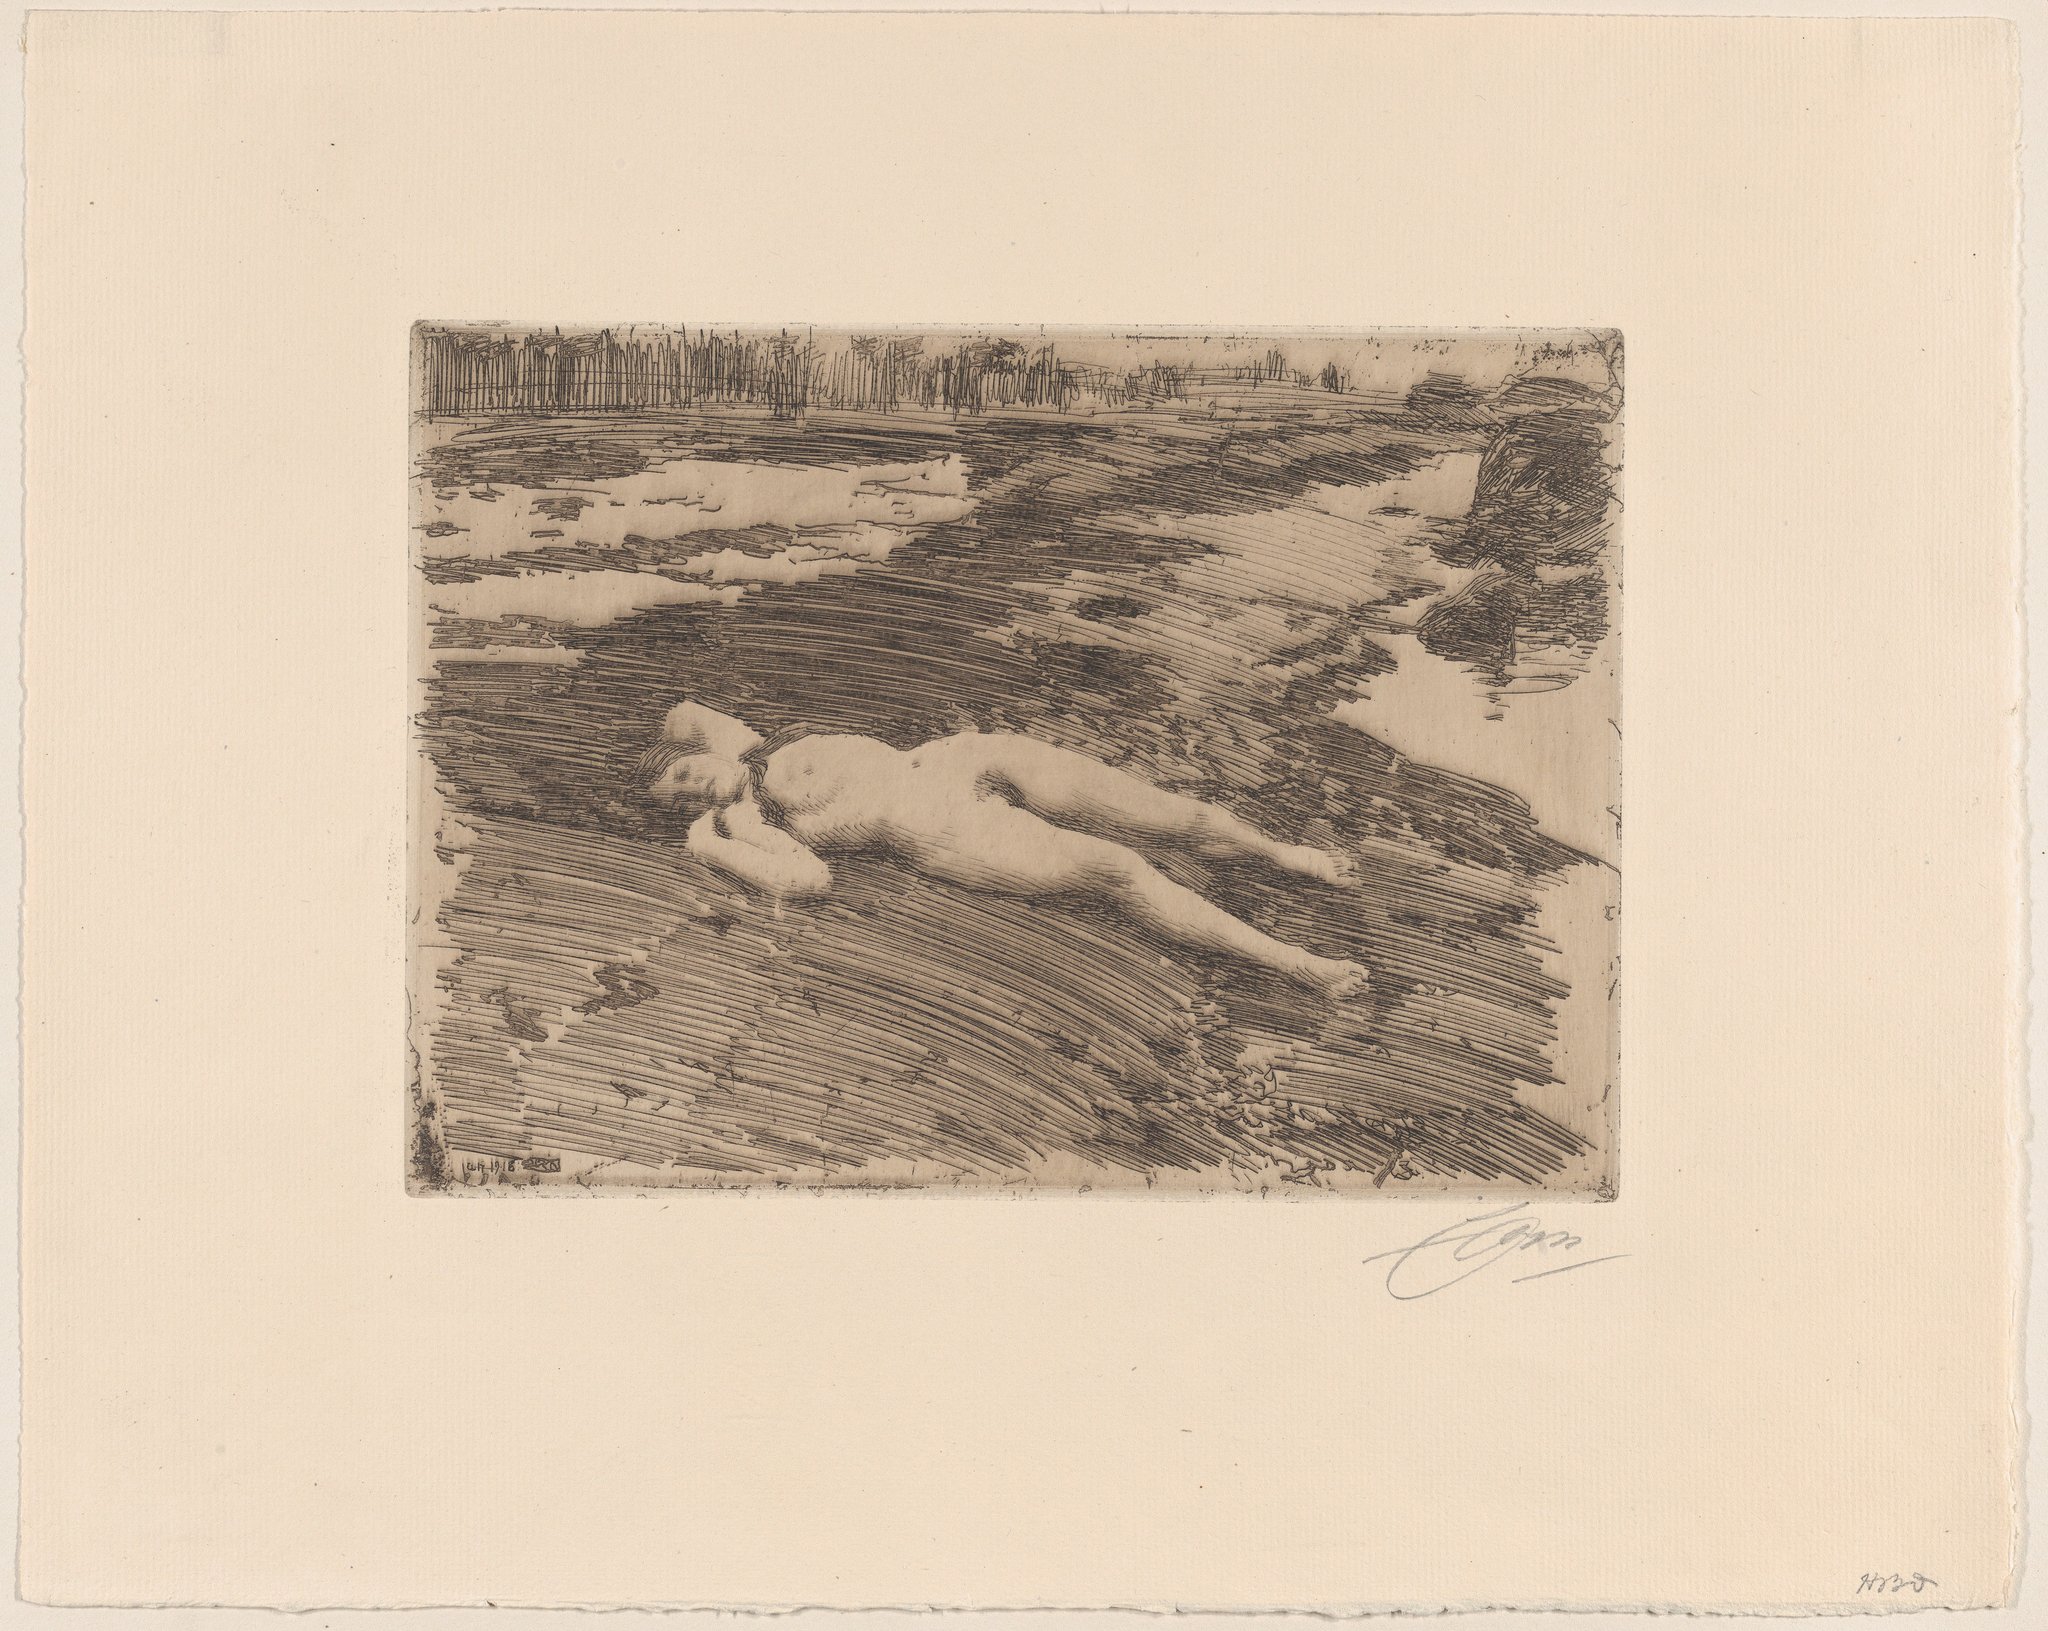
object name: print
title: On the Sands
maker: anders zorn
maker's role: artist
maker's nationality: swedish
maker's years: 1860-1920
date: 1916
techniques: etching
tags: female nudes